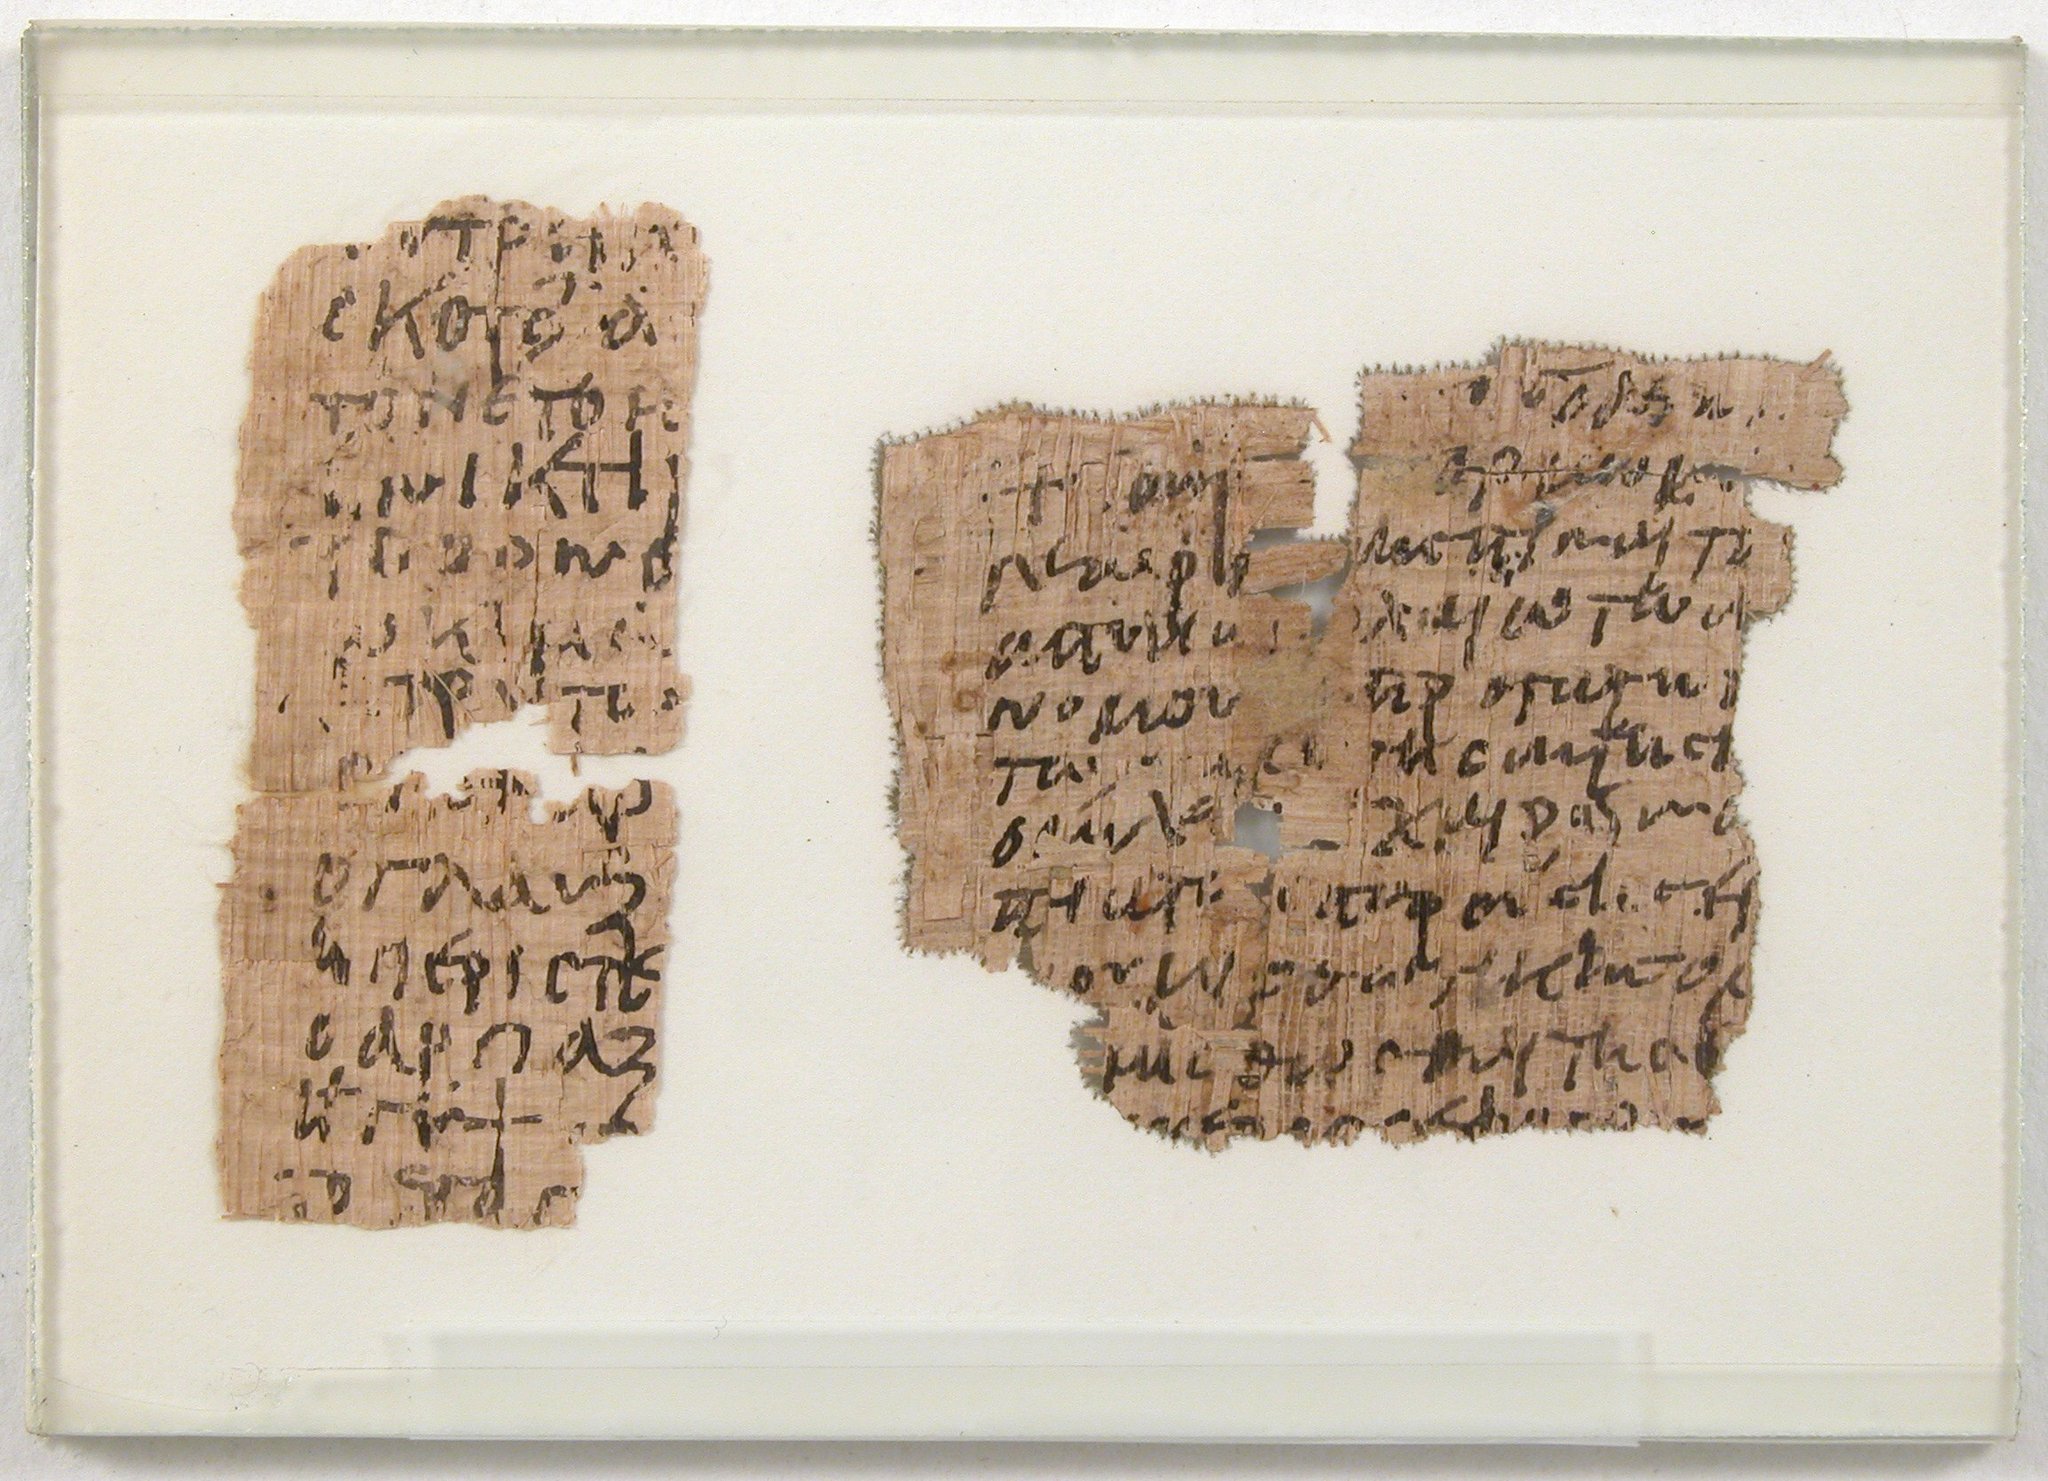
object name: fragment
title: Papyrus Fragment of a Letter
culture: coptic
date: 580-640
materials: ink, papyrus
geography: egypt